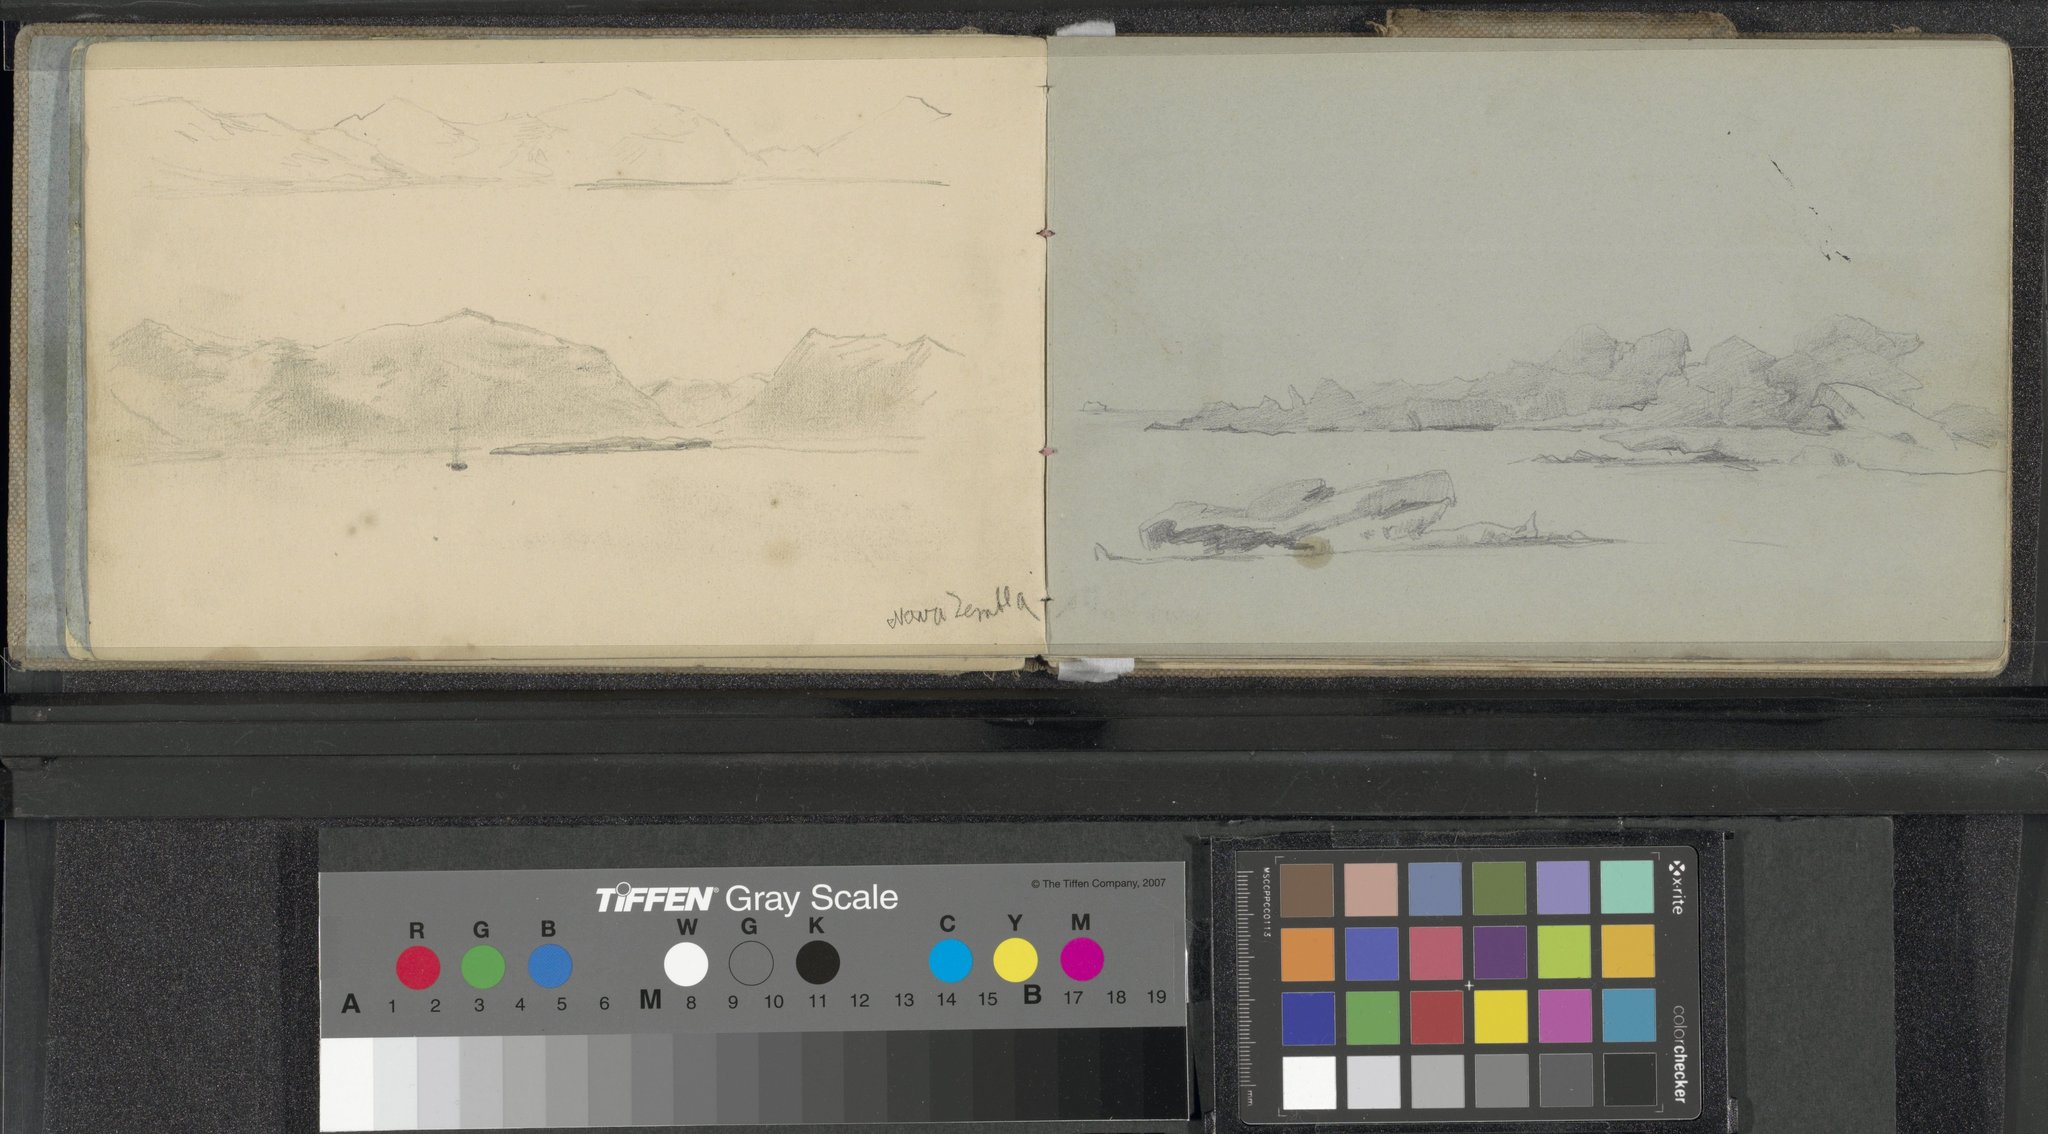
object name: sketchbook leaf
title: Gezicht op Nova Zembla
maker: louis apol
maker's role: draughtsman, painter, print maker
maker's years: 1850-1936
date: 1880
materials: paper, pencil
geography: novaya zemlya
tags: coast (in polar regions), ships (in general)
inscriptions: annotation: ‘Nova Zembla’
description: Voor de kust een schip, mogelijk de Willem Barents. Blad 9 verso uit een schetsboek met 35 bladen betekend tijdens de expeditie naar Nova Zembla in 1880.